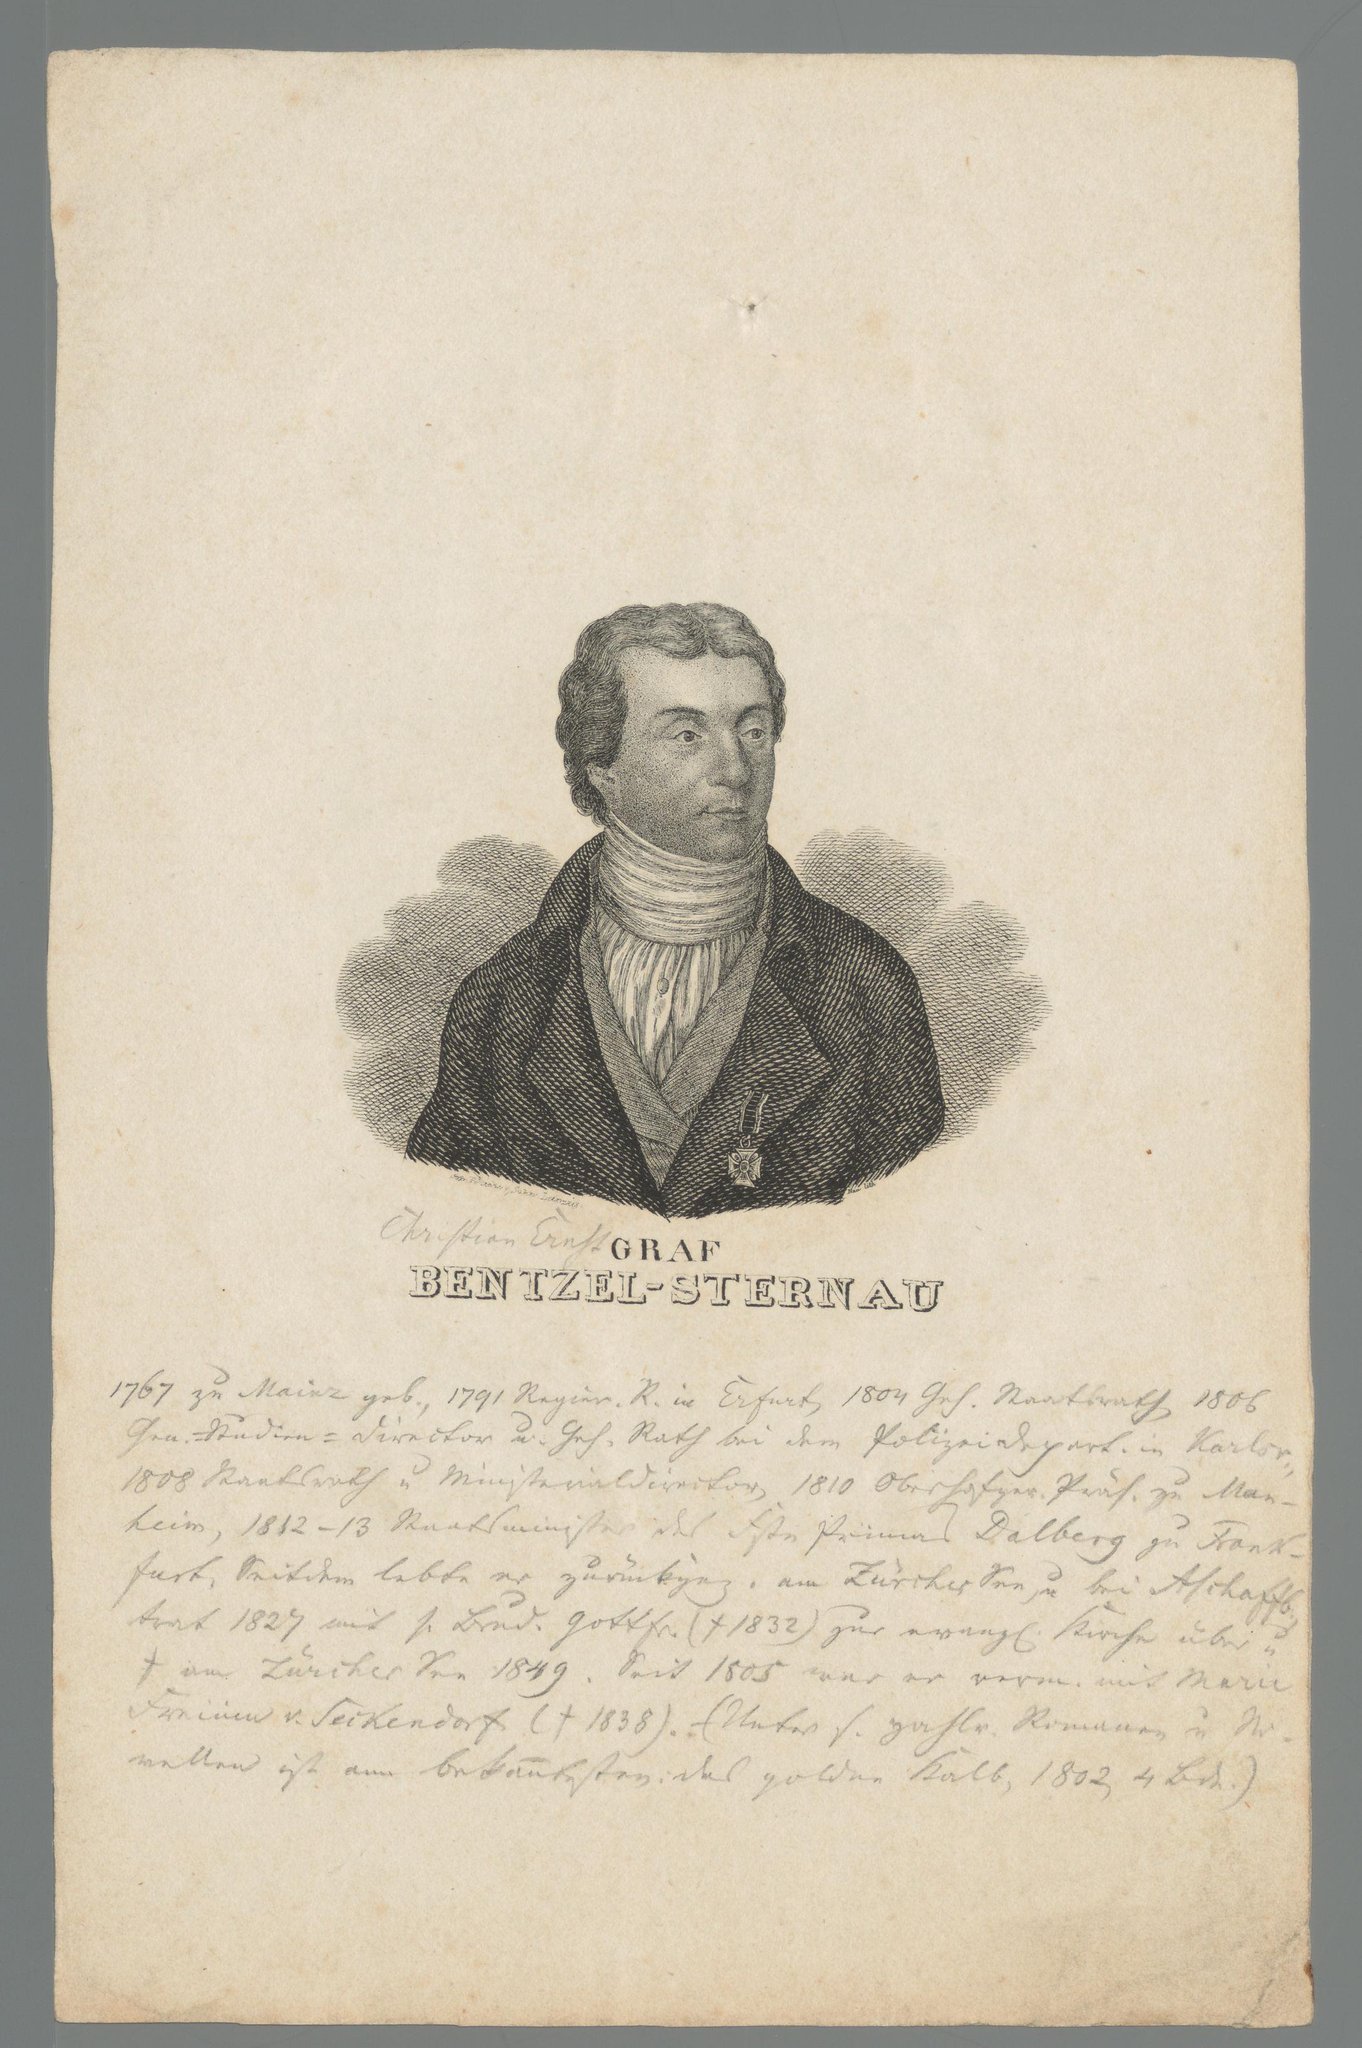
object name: print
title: Graf Bentzel-Sternau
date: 1818-1899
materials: paper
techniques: lithograph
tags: adult man, historical persons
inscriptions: collector's mark: Lugt 2228, inscription: ‘1767 in Mainz geb. (...) 4 bd’